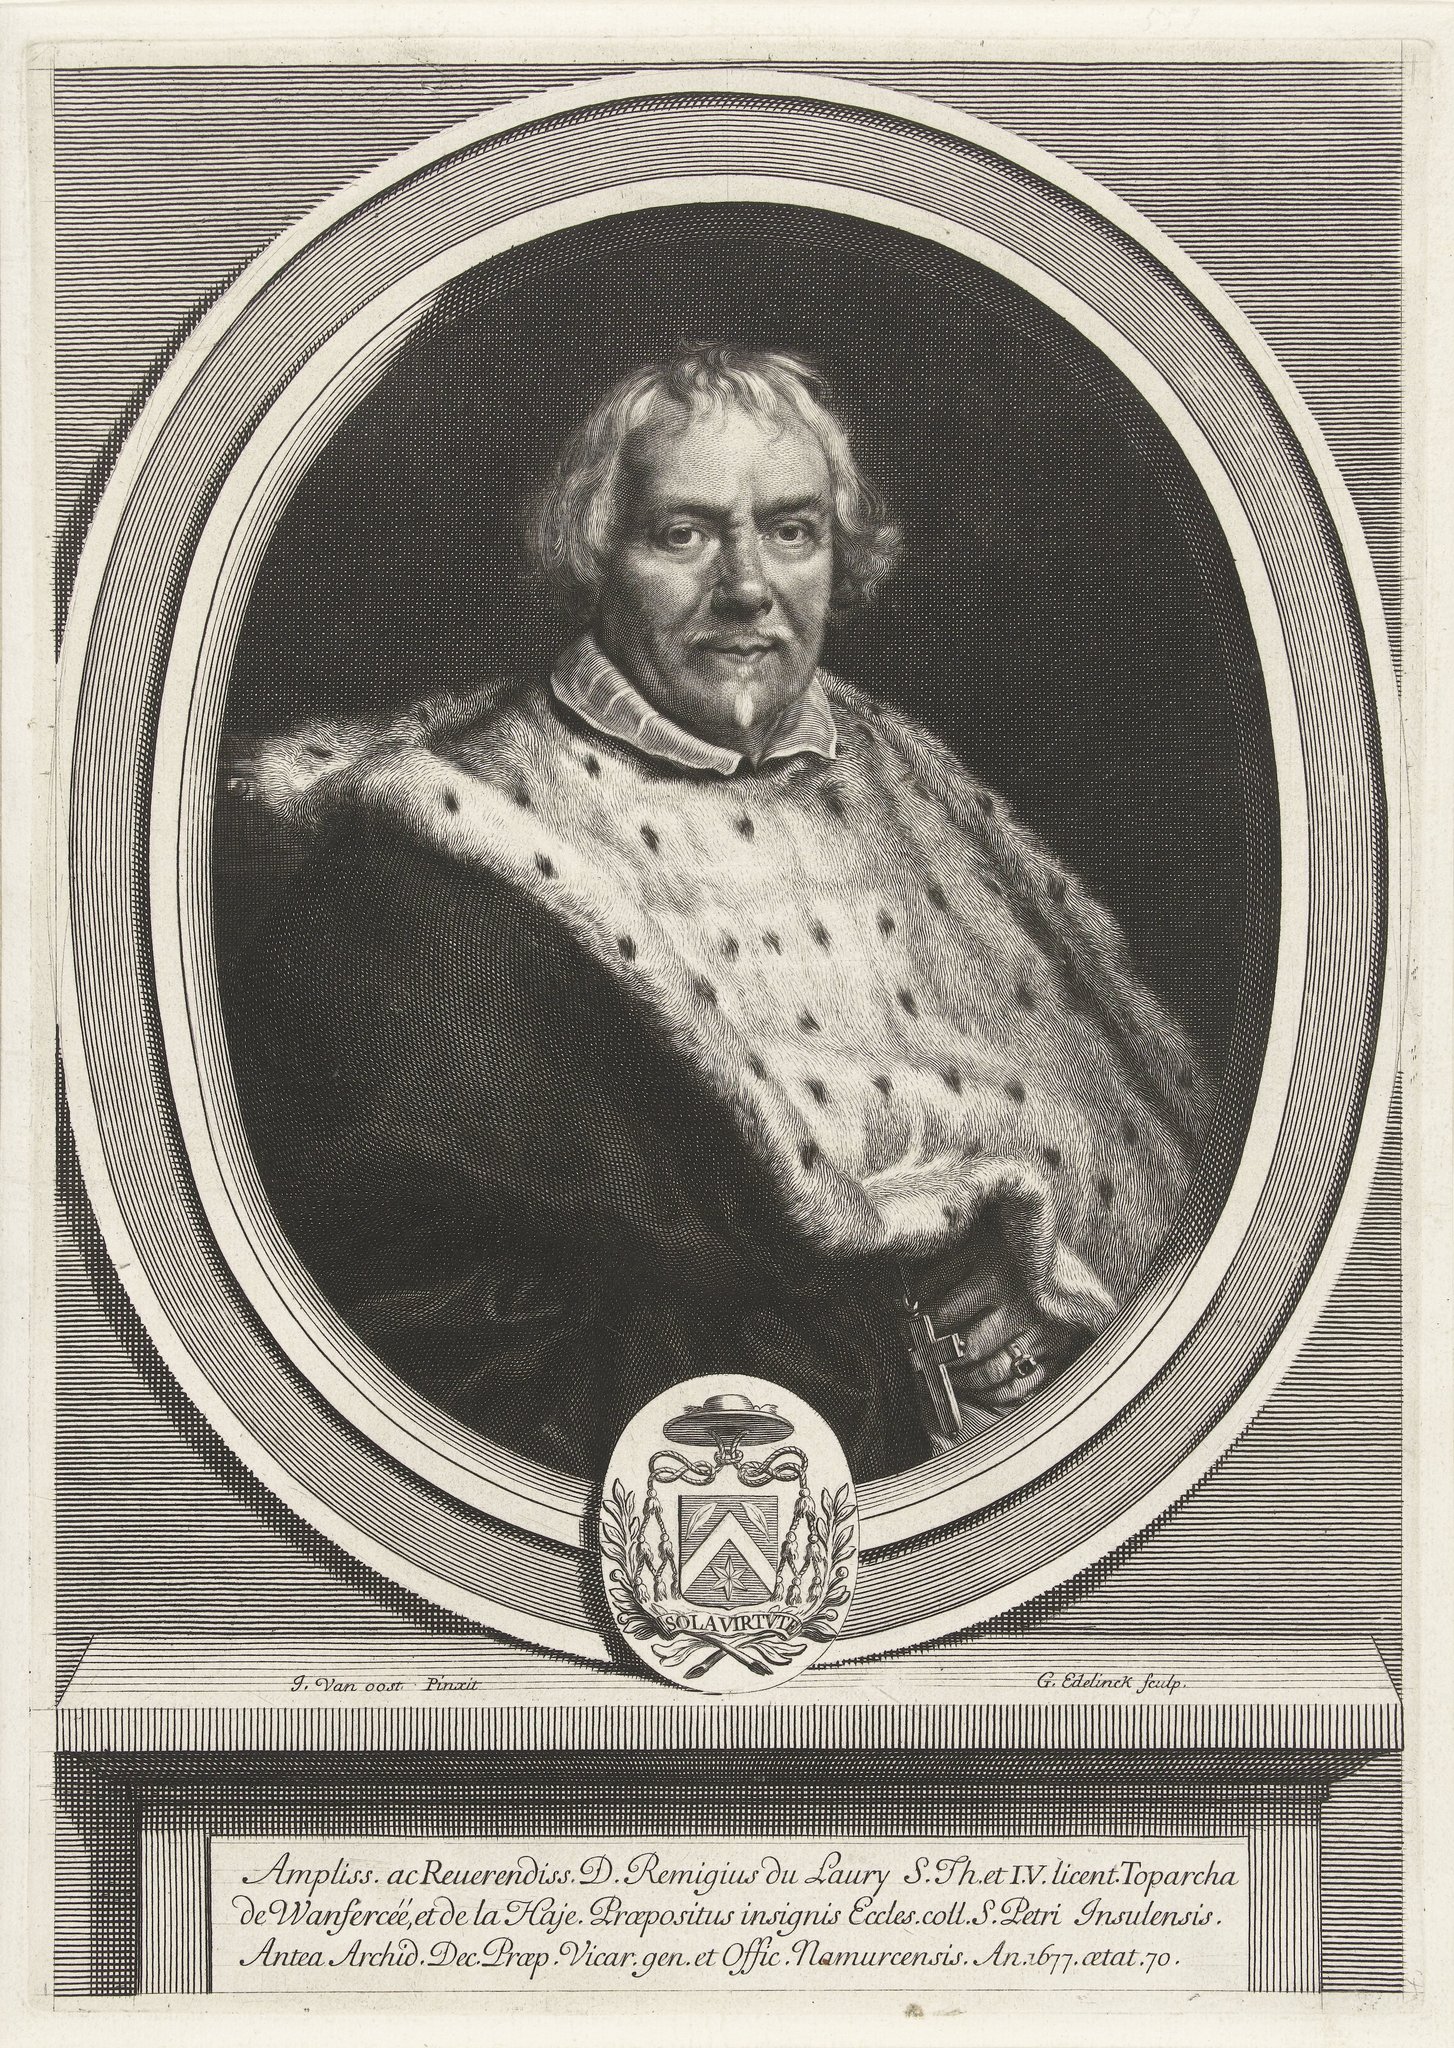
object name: print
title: Portret van Remy du Laury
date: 1676-1707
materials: paper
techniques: engraving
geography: paris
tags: remi du laury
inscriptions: collector's mark: Lugt 2228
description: Portret van Remy du Laury, proost van de Sint-Pierre kerk in Lille. Afgebeeld in ovale omlijsting met wapen, waaronder drie regels tekst in Latijn.